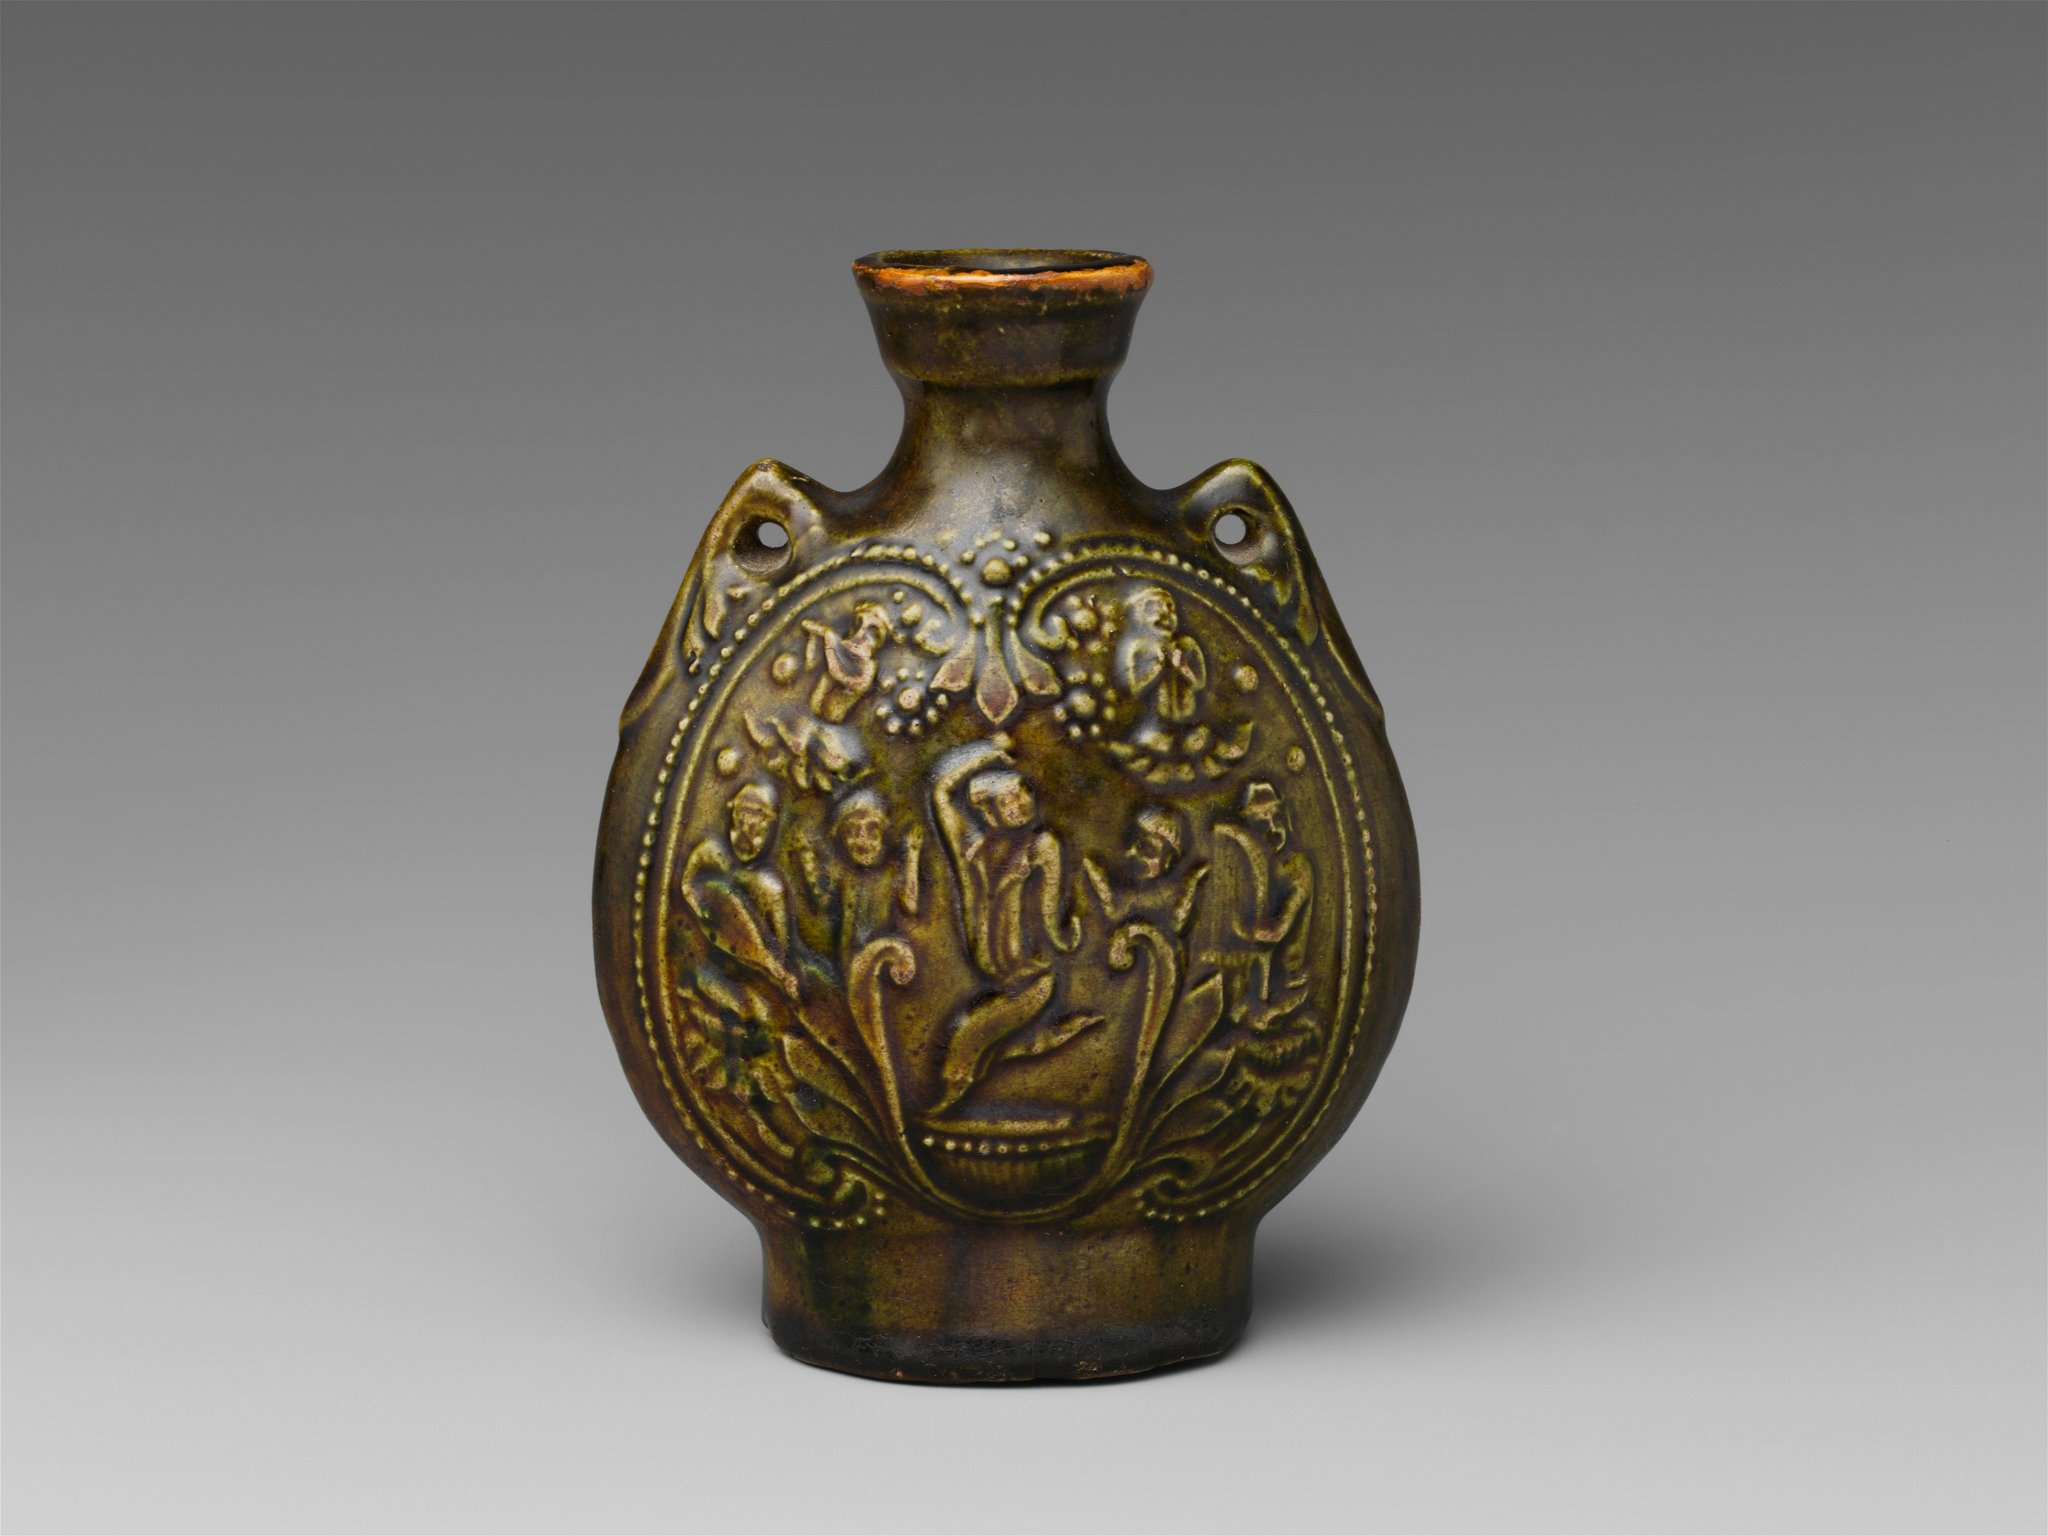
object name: flask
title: Pilgrim’s flask with Central Asian dancers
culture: chinese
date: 567-600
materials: earthenware, glaze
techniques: molding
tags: dancers